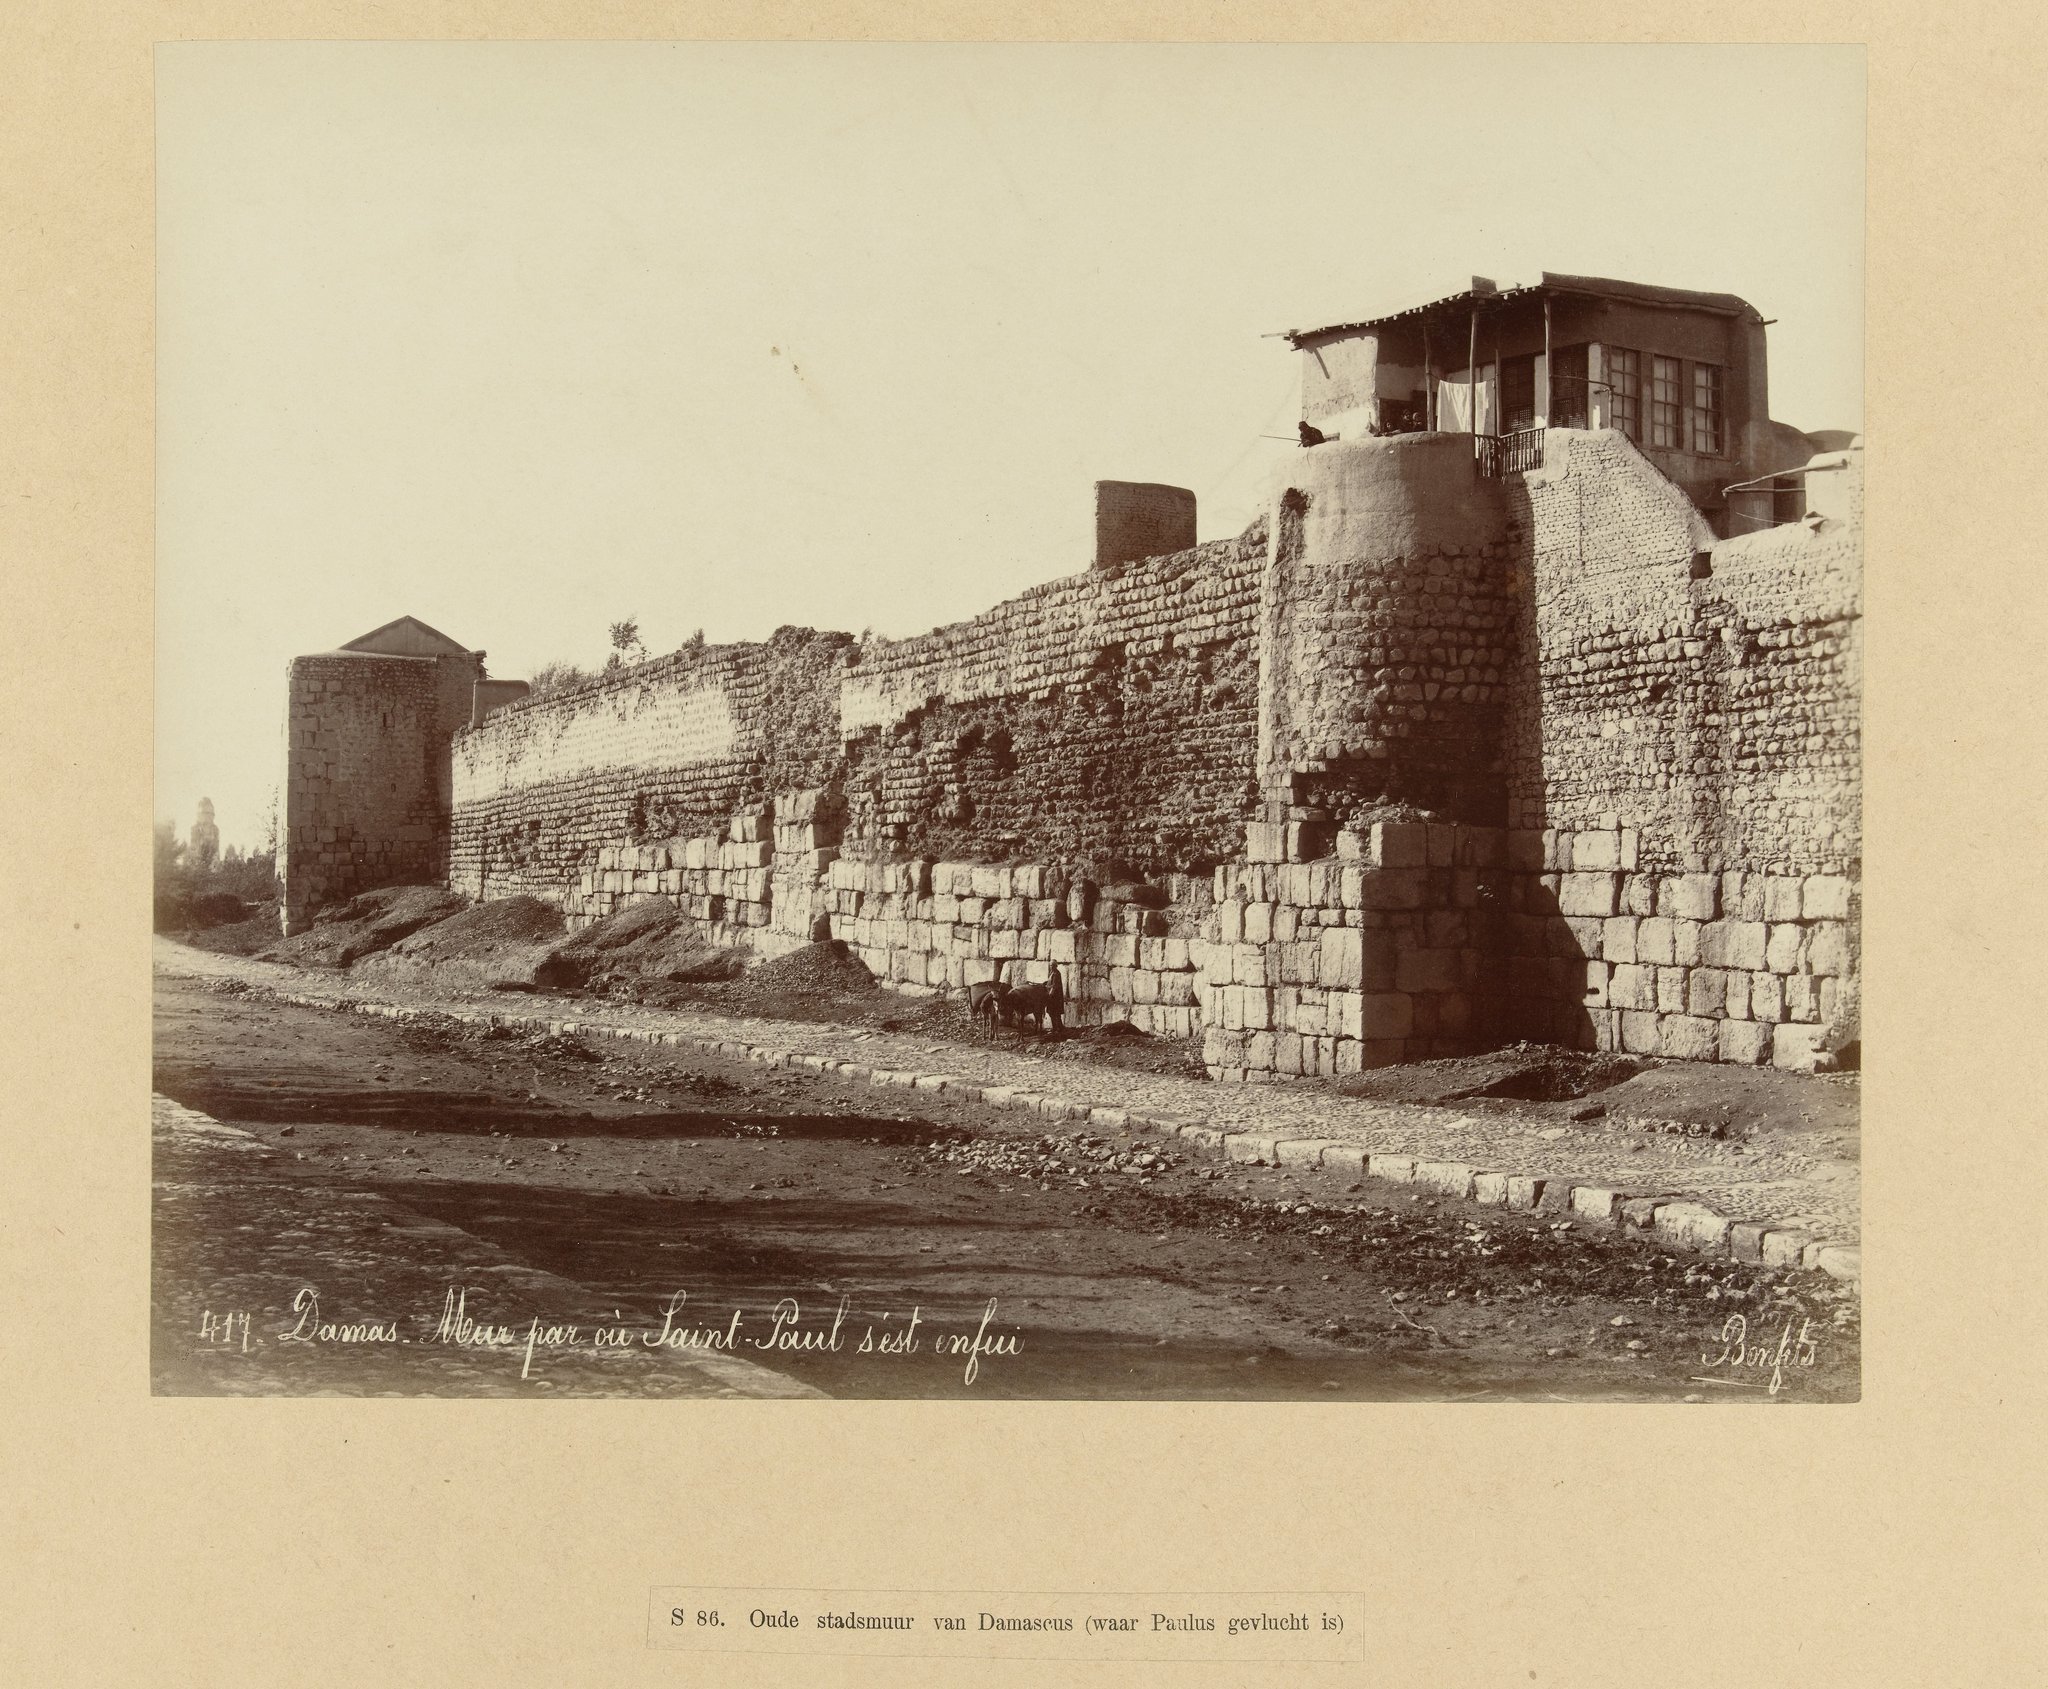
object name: photograph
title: S 86. Oude stadsmuur van Damascus (waar Paulus gevlucht is)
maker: félix bonfils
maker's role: fotograaf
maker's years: 1831-1885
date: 1867-1877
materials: cardboard, paper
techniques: albumen print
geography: damascus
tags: city-walls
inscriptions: title: ‘S 86. Oude stadsmuur van Damascus (waar Paulus gevlucht is)’, number: ‘417’, stamp: ‘Gemeentelijke bibliotheek/ Rotterdam’, check stamp: ‘Bristol/ L.M.’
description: Onderdeel van een groep door fotograaf Richard Polak op reis verzamelde foto’s. Deze foto is samen met andere op zijn reizen verzamelde foto's tentoongesteld bij de Rotterdamsche Kunstkring (1895), Arti en Amicitiae te Amsterdam (1897-1898?) en Societeit 't Collegie te Kampen (datum vooralsnog onbekend).